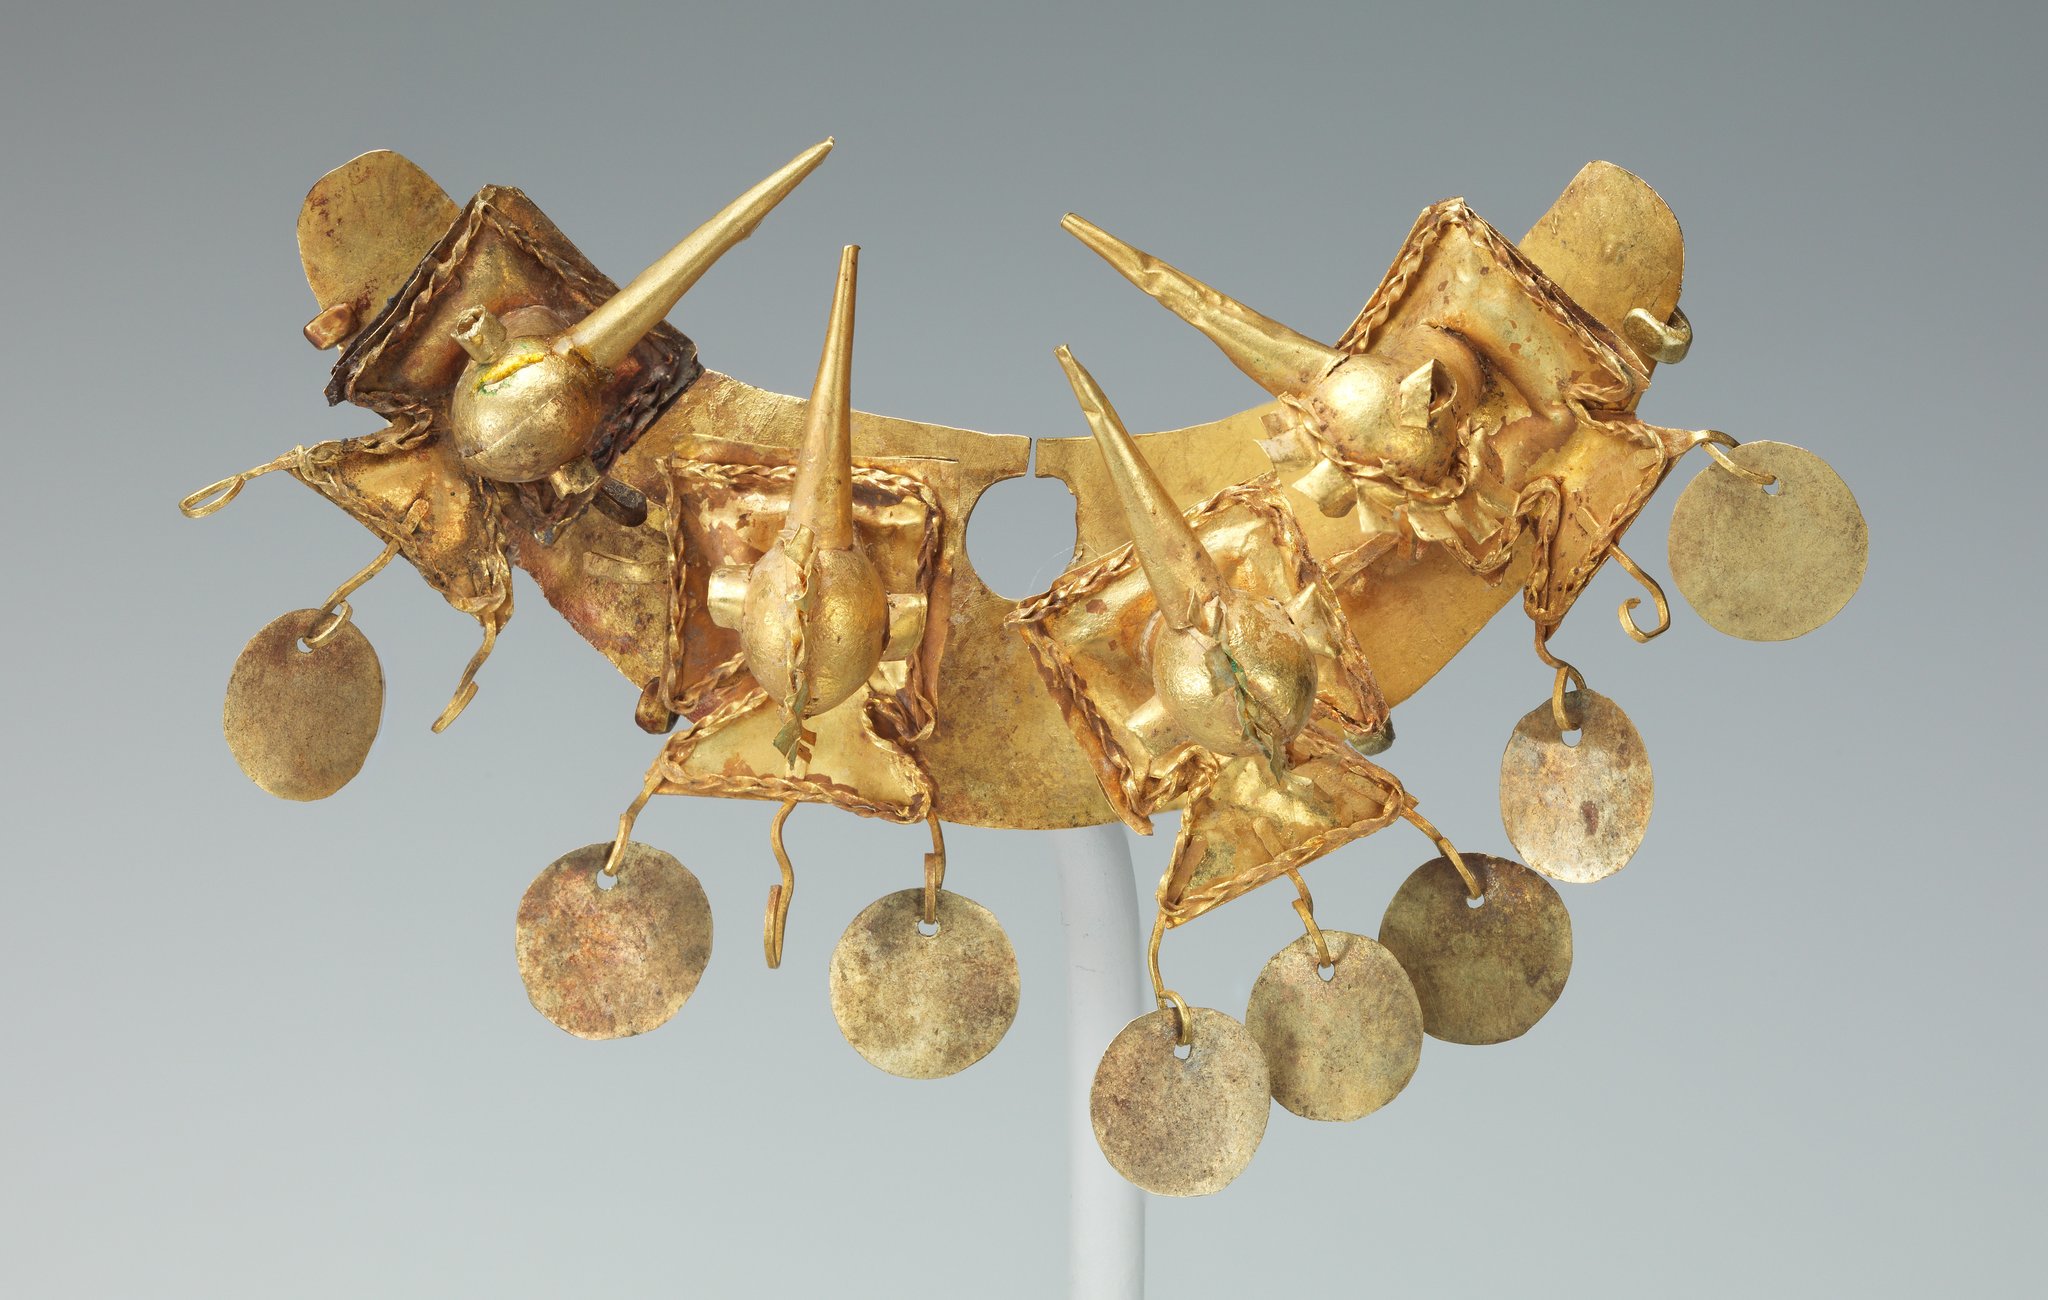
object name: nose ornament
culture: frías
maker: frías artist(s)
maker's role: artist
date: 300-600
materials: gold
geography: peru